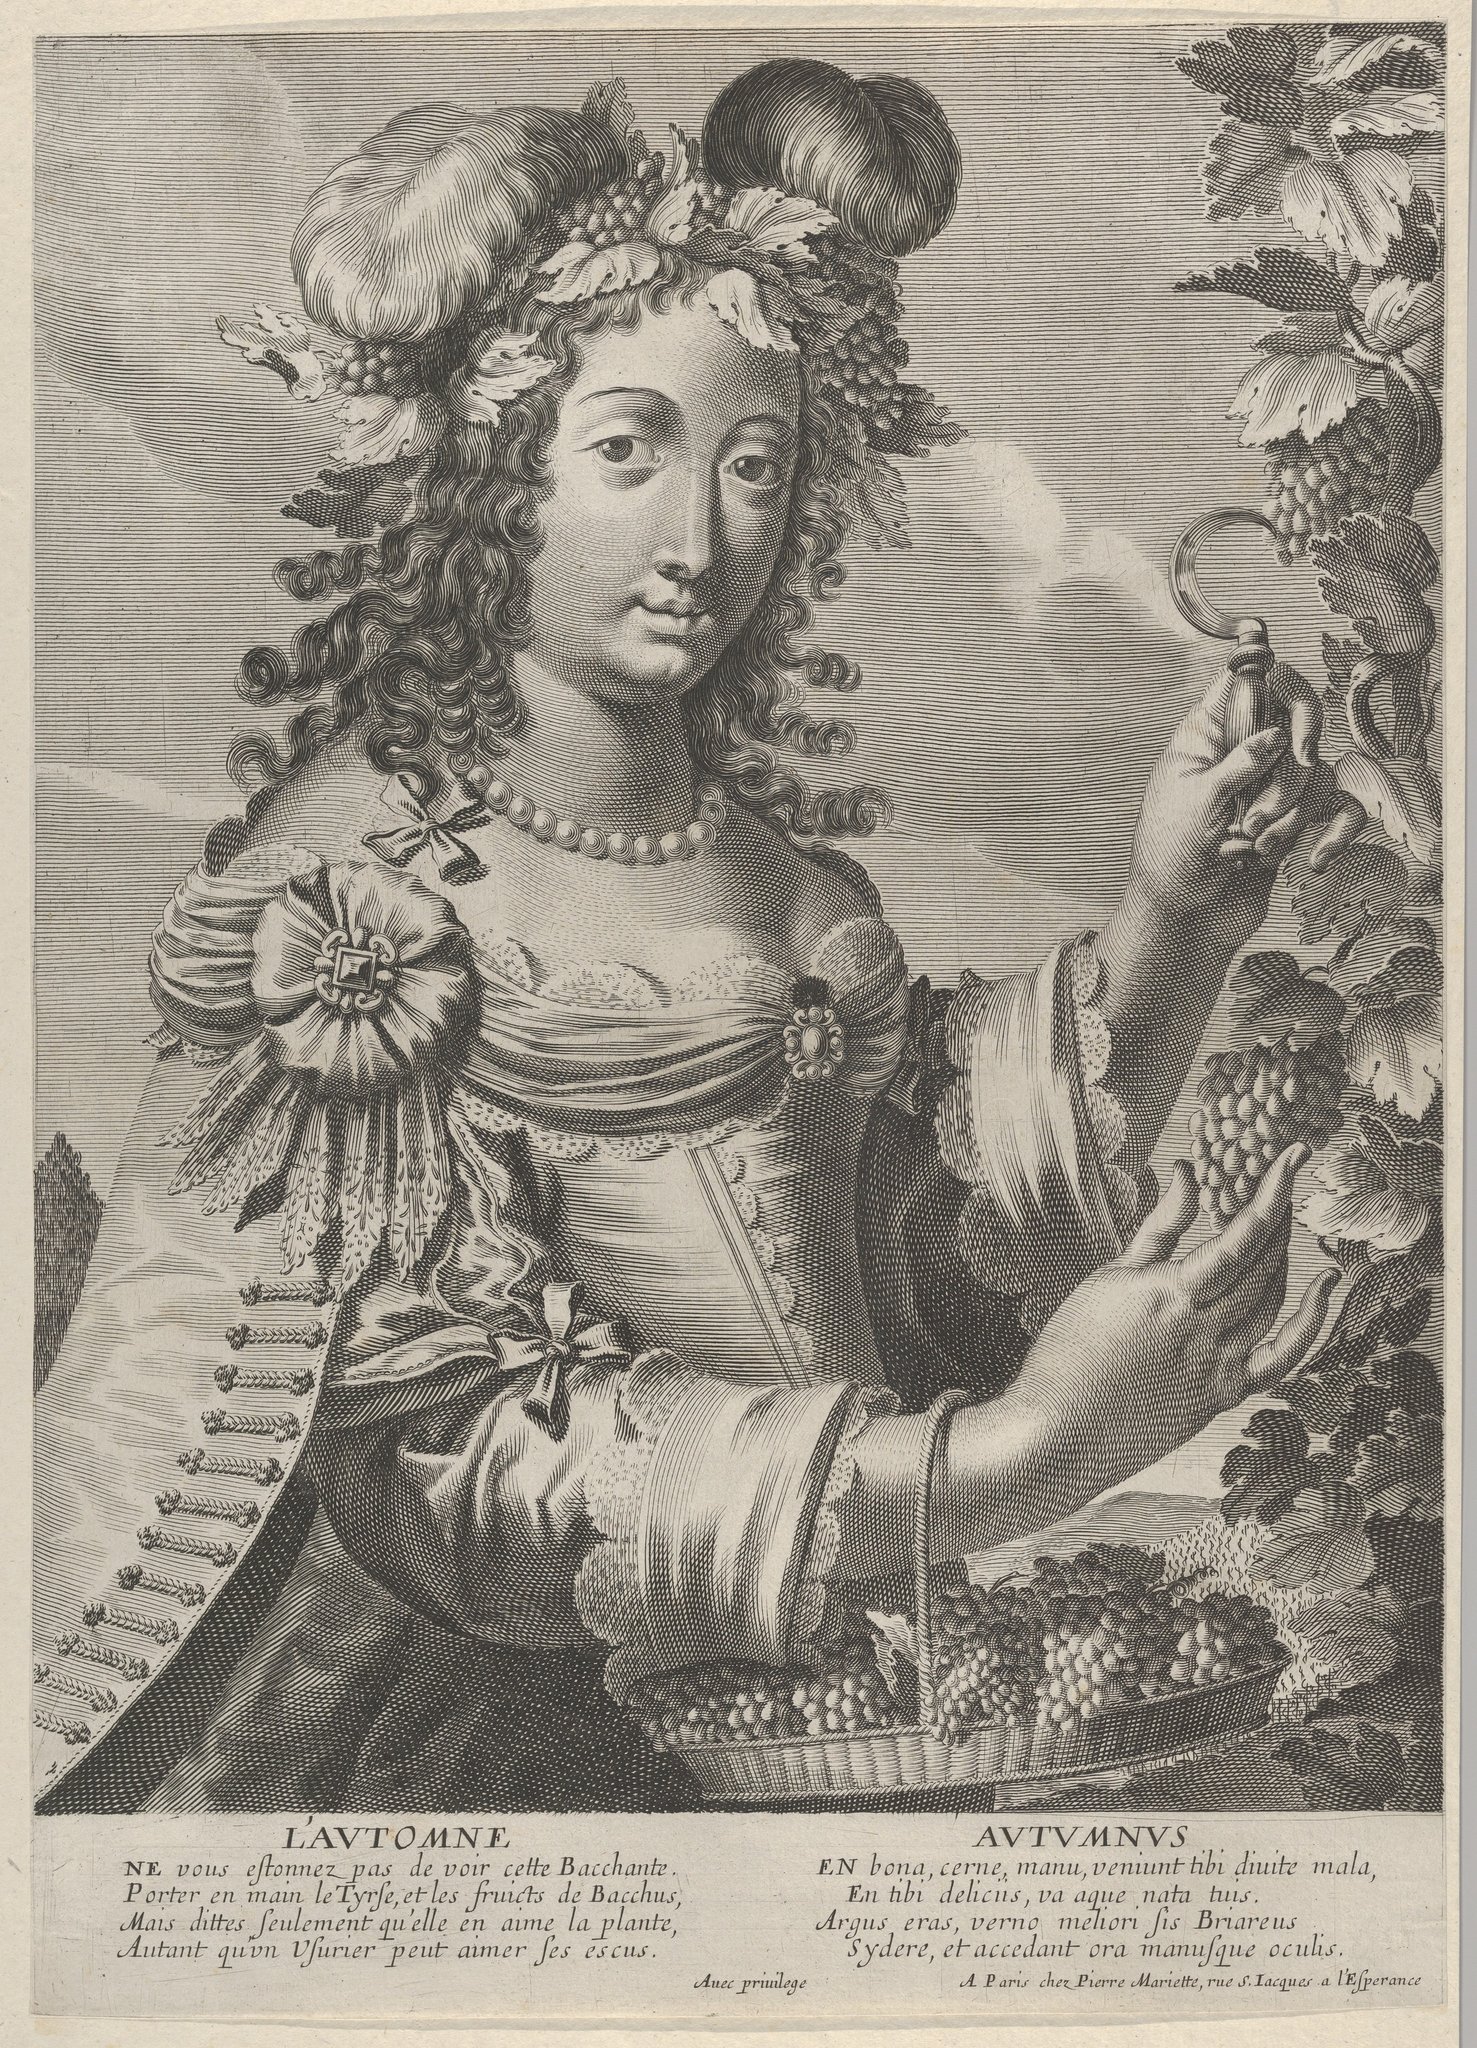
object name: print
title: Autumn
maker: grégoire huret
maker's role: artist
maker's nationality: french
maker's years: 1606-1670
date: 1620-1670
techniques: engraving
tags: grapes,portraits,women,autumn